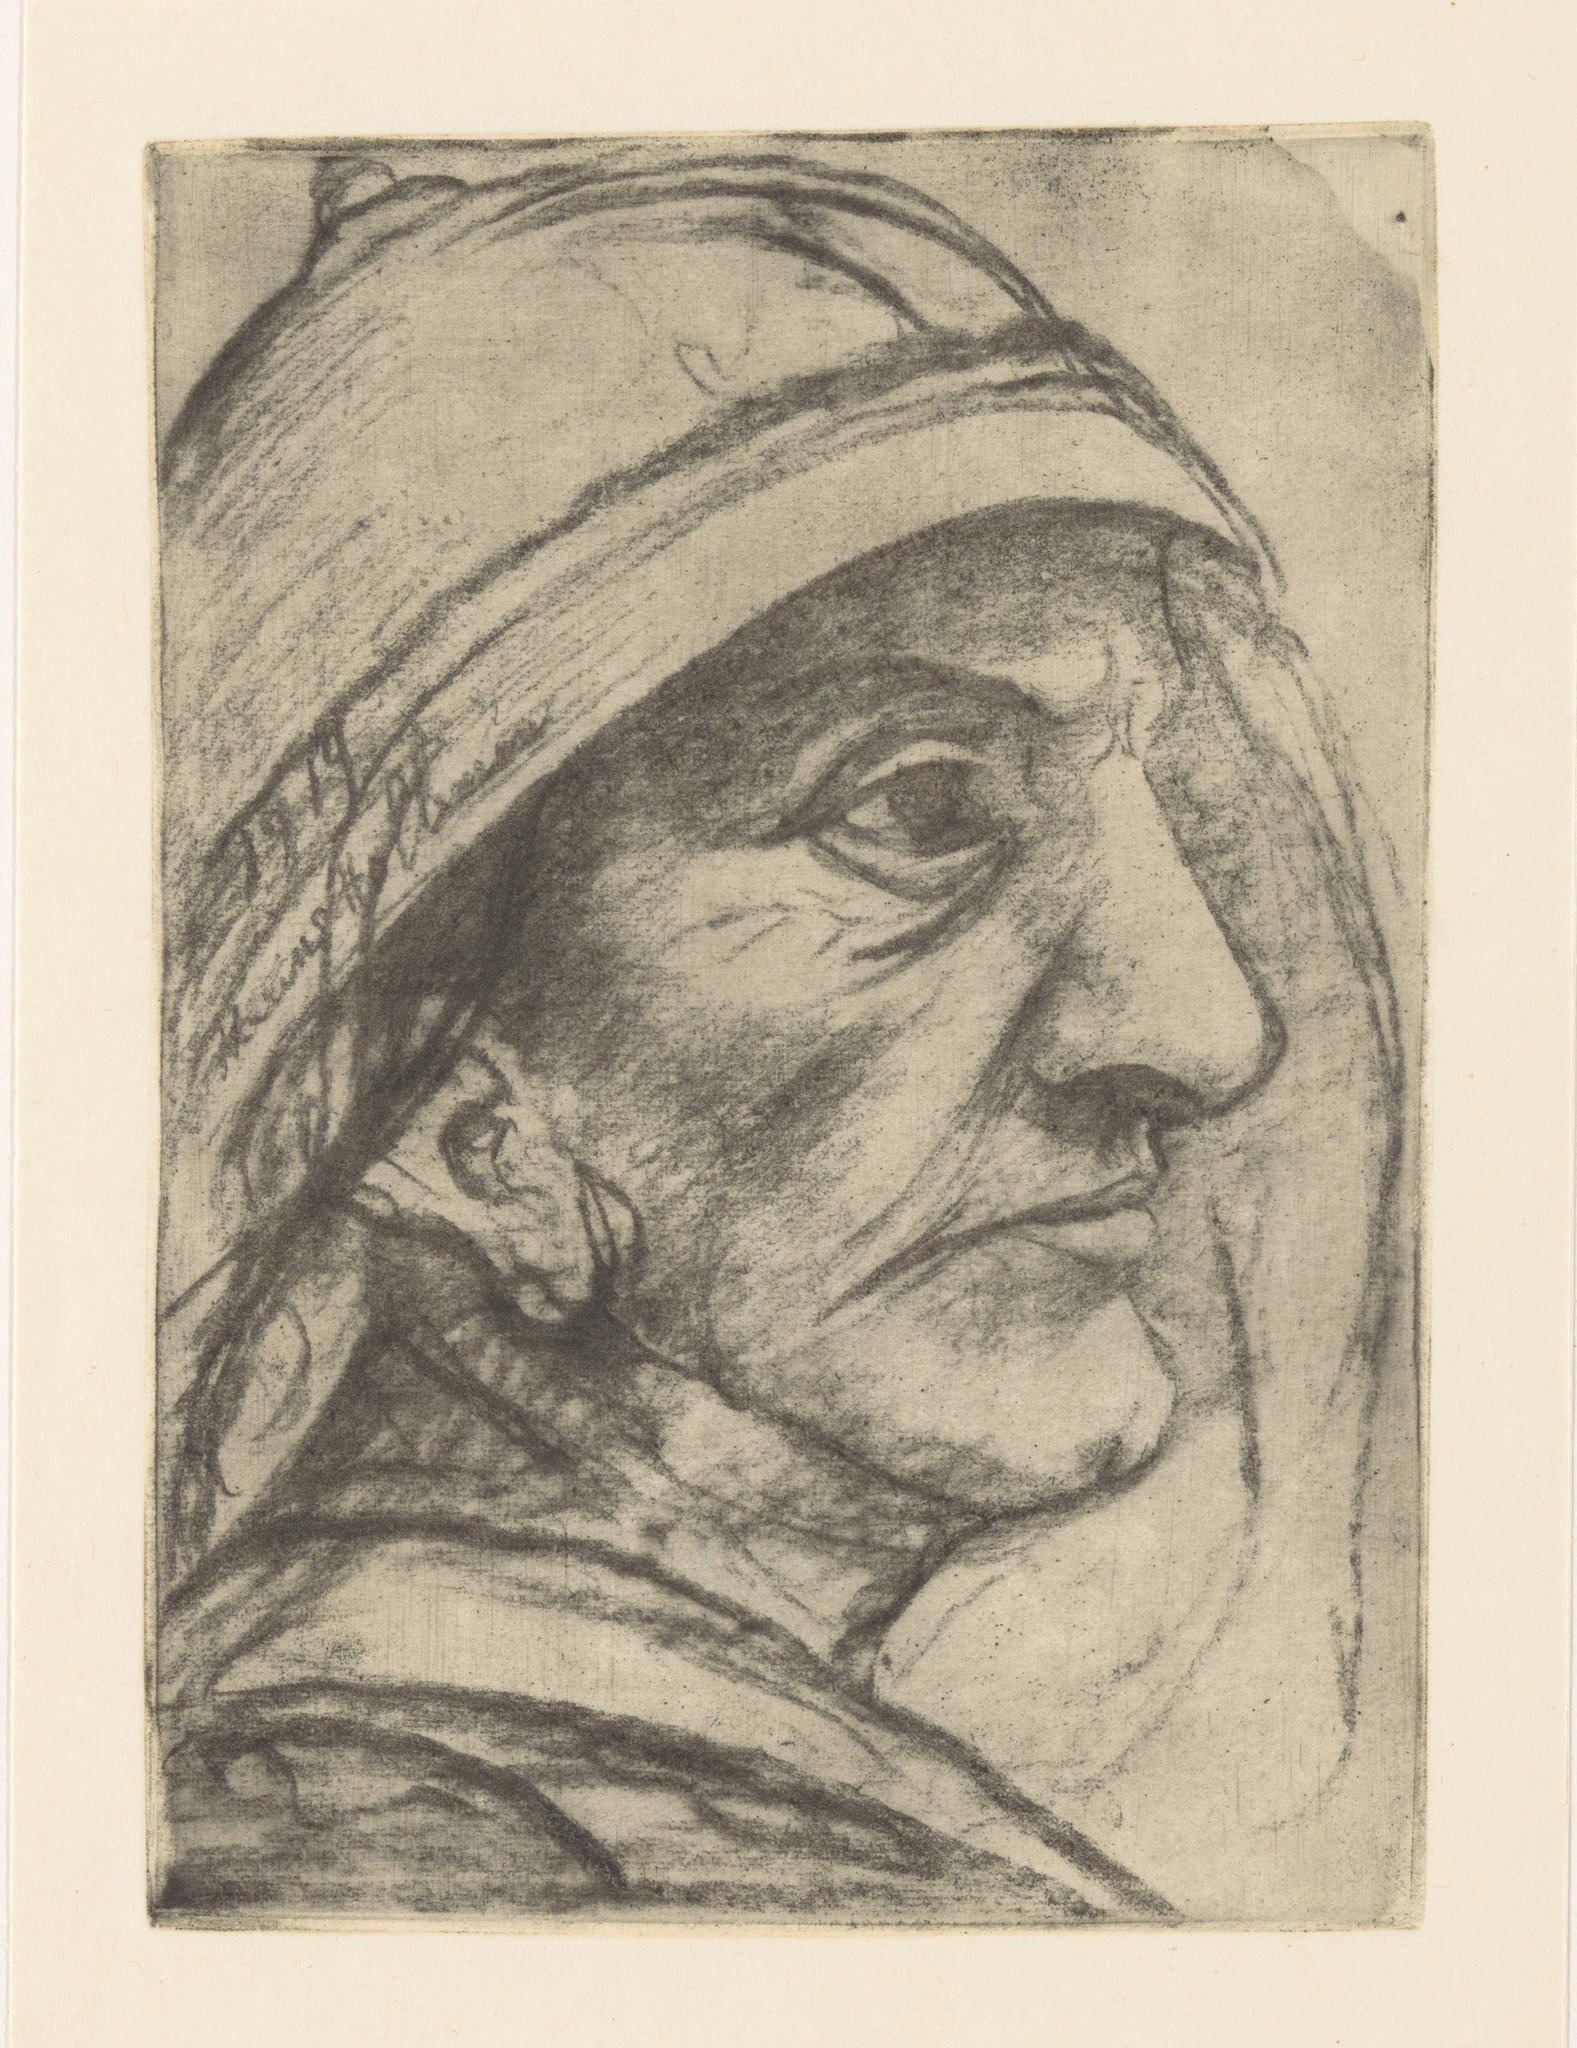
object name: print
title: Man met helm en profil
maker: marius holleman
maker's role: draughtsman, print maker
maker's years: 1878-1926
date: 1919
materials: paper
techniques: etching, intaglio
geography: groningen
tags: helmet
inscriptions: collector's mark: Lugt 2228